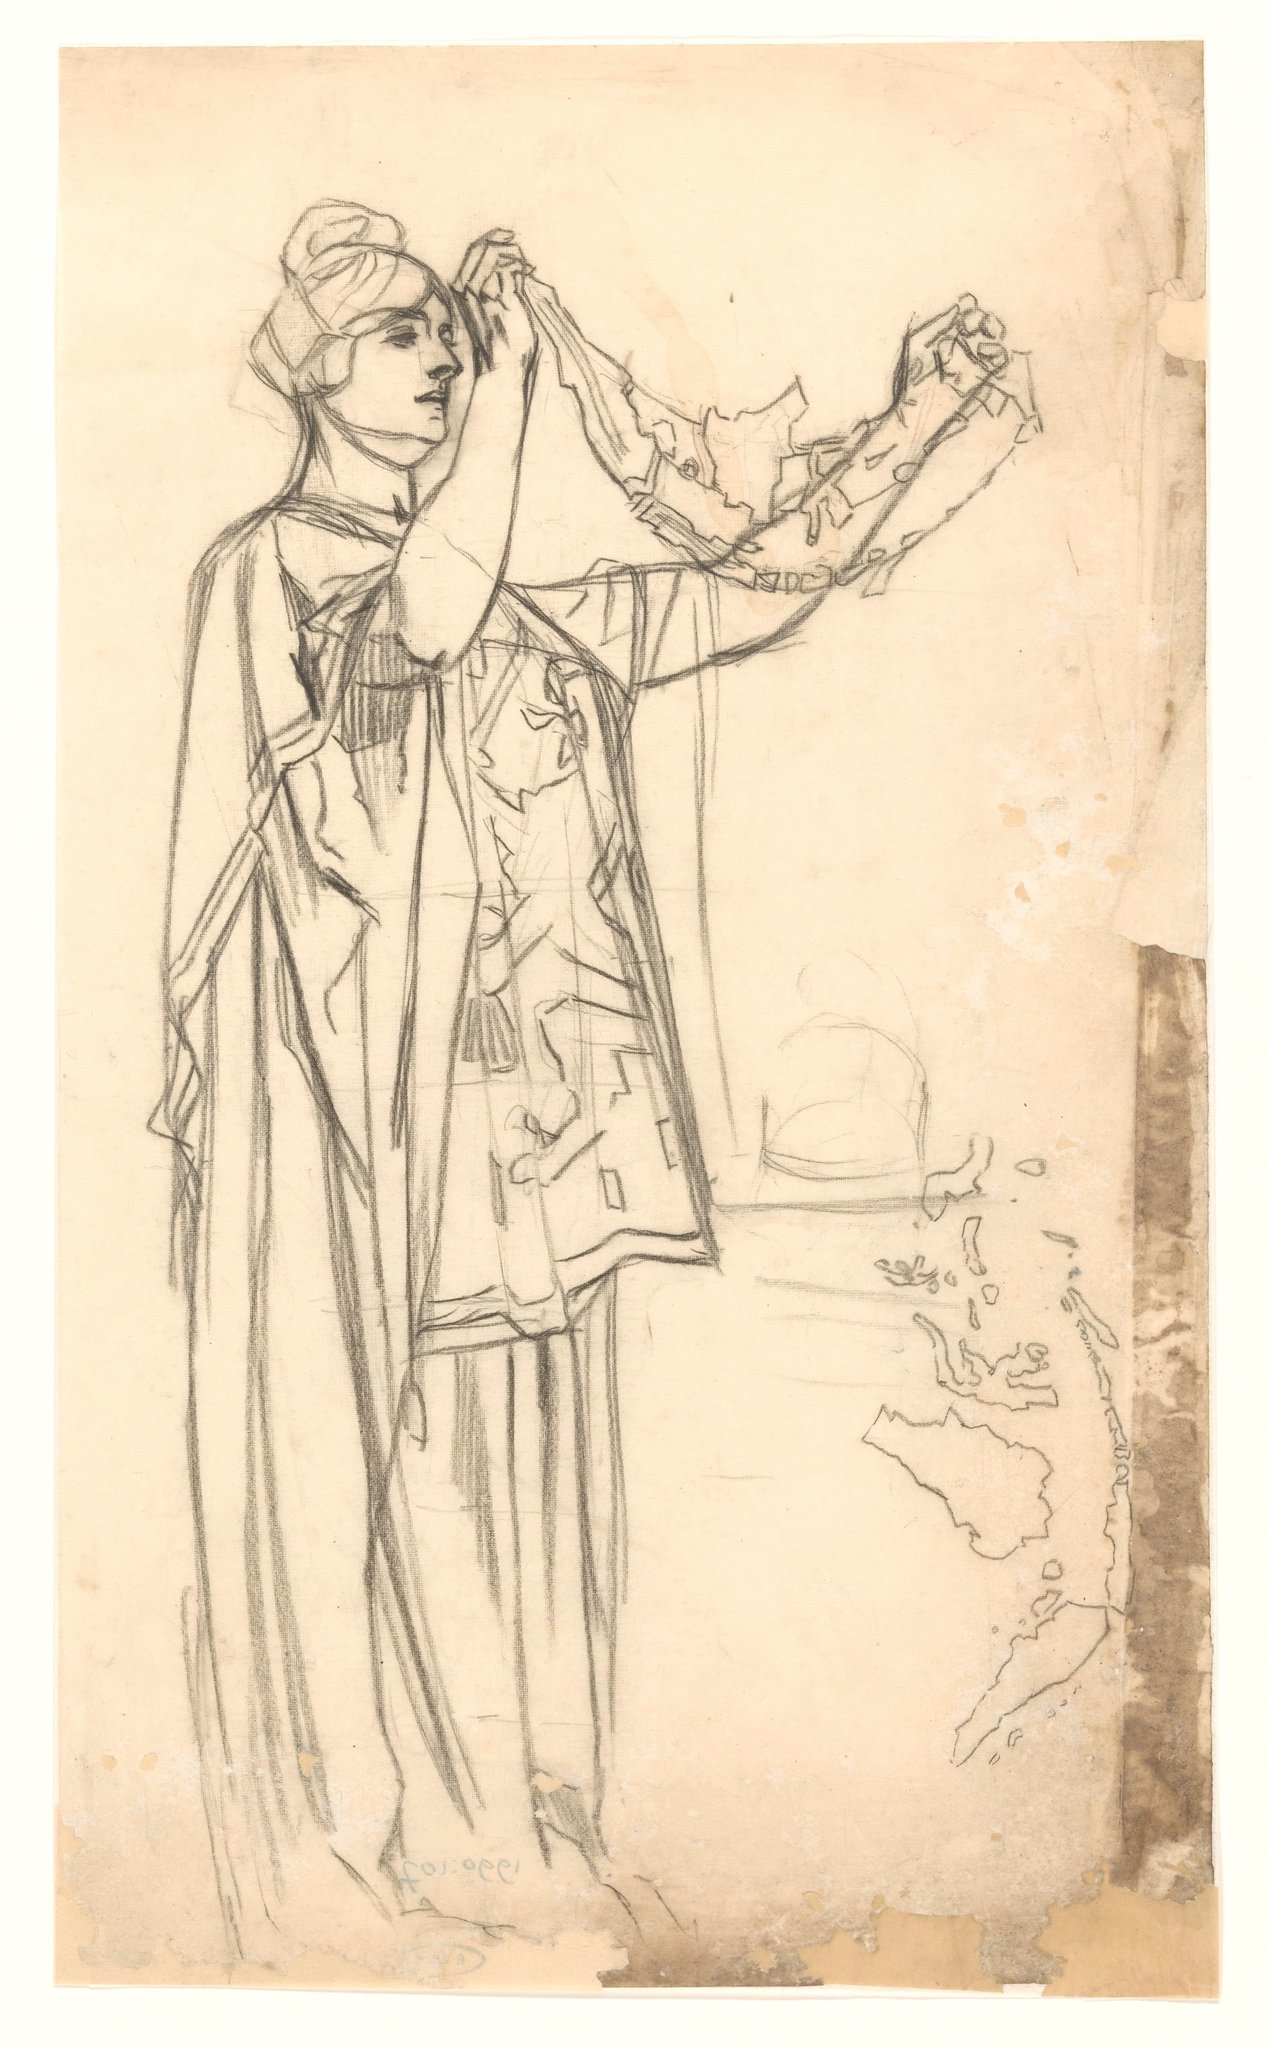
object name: design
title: Ontwerp voor illustratie in De Amsterdammer: de Nederlandse Maagd houdt de Indonesische eilandenarchipel omhoog (14 October 1916)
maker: johan braakensiek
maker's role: draughtsman, print maker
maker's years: 1858-1940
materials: chalk, pencil, paper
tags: political caricatures and satires